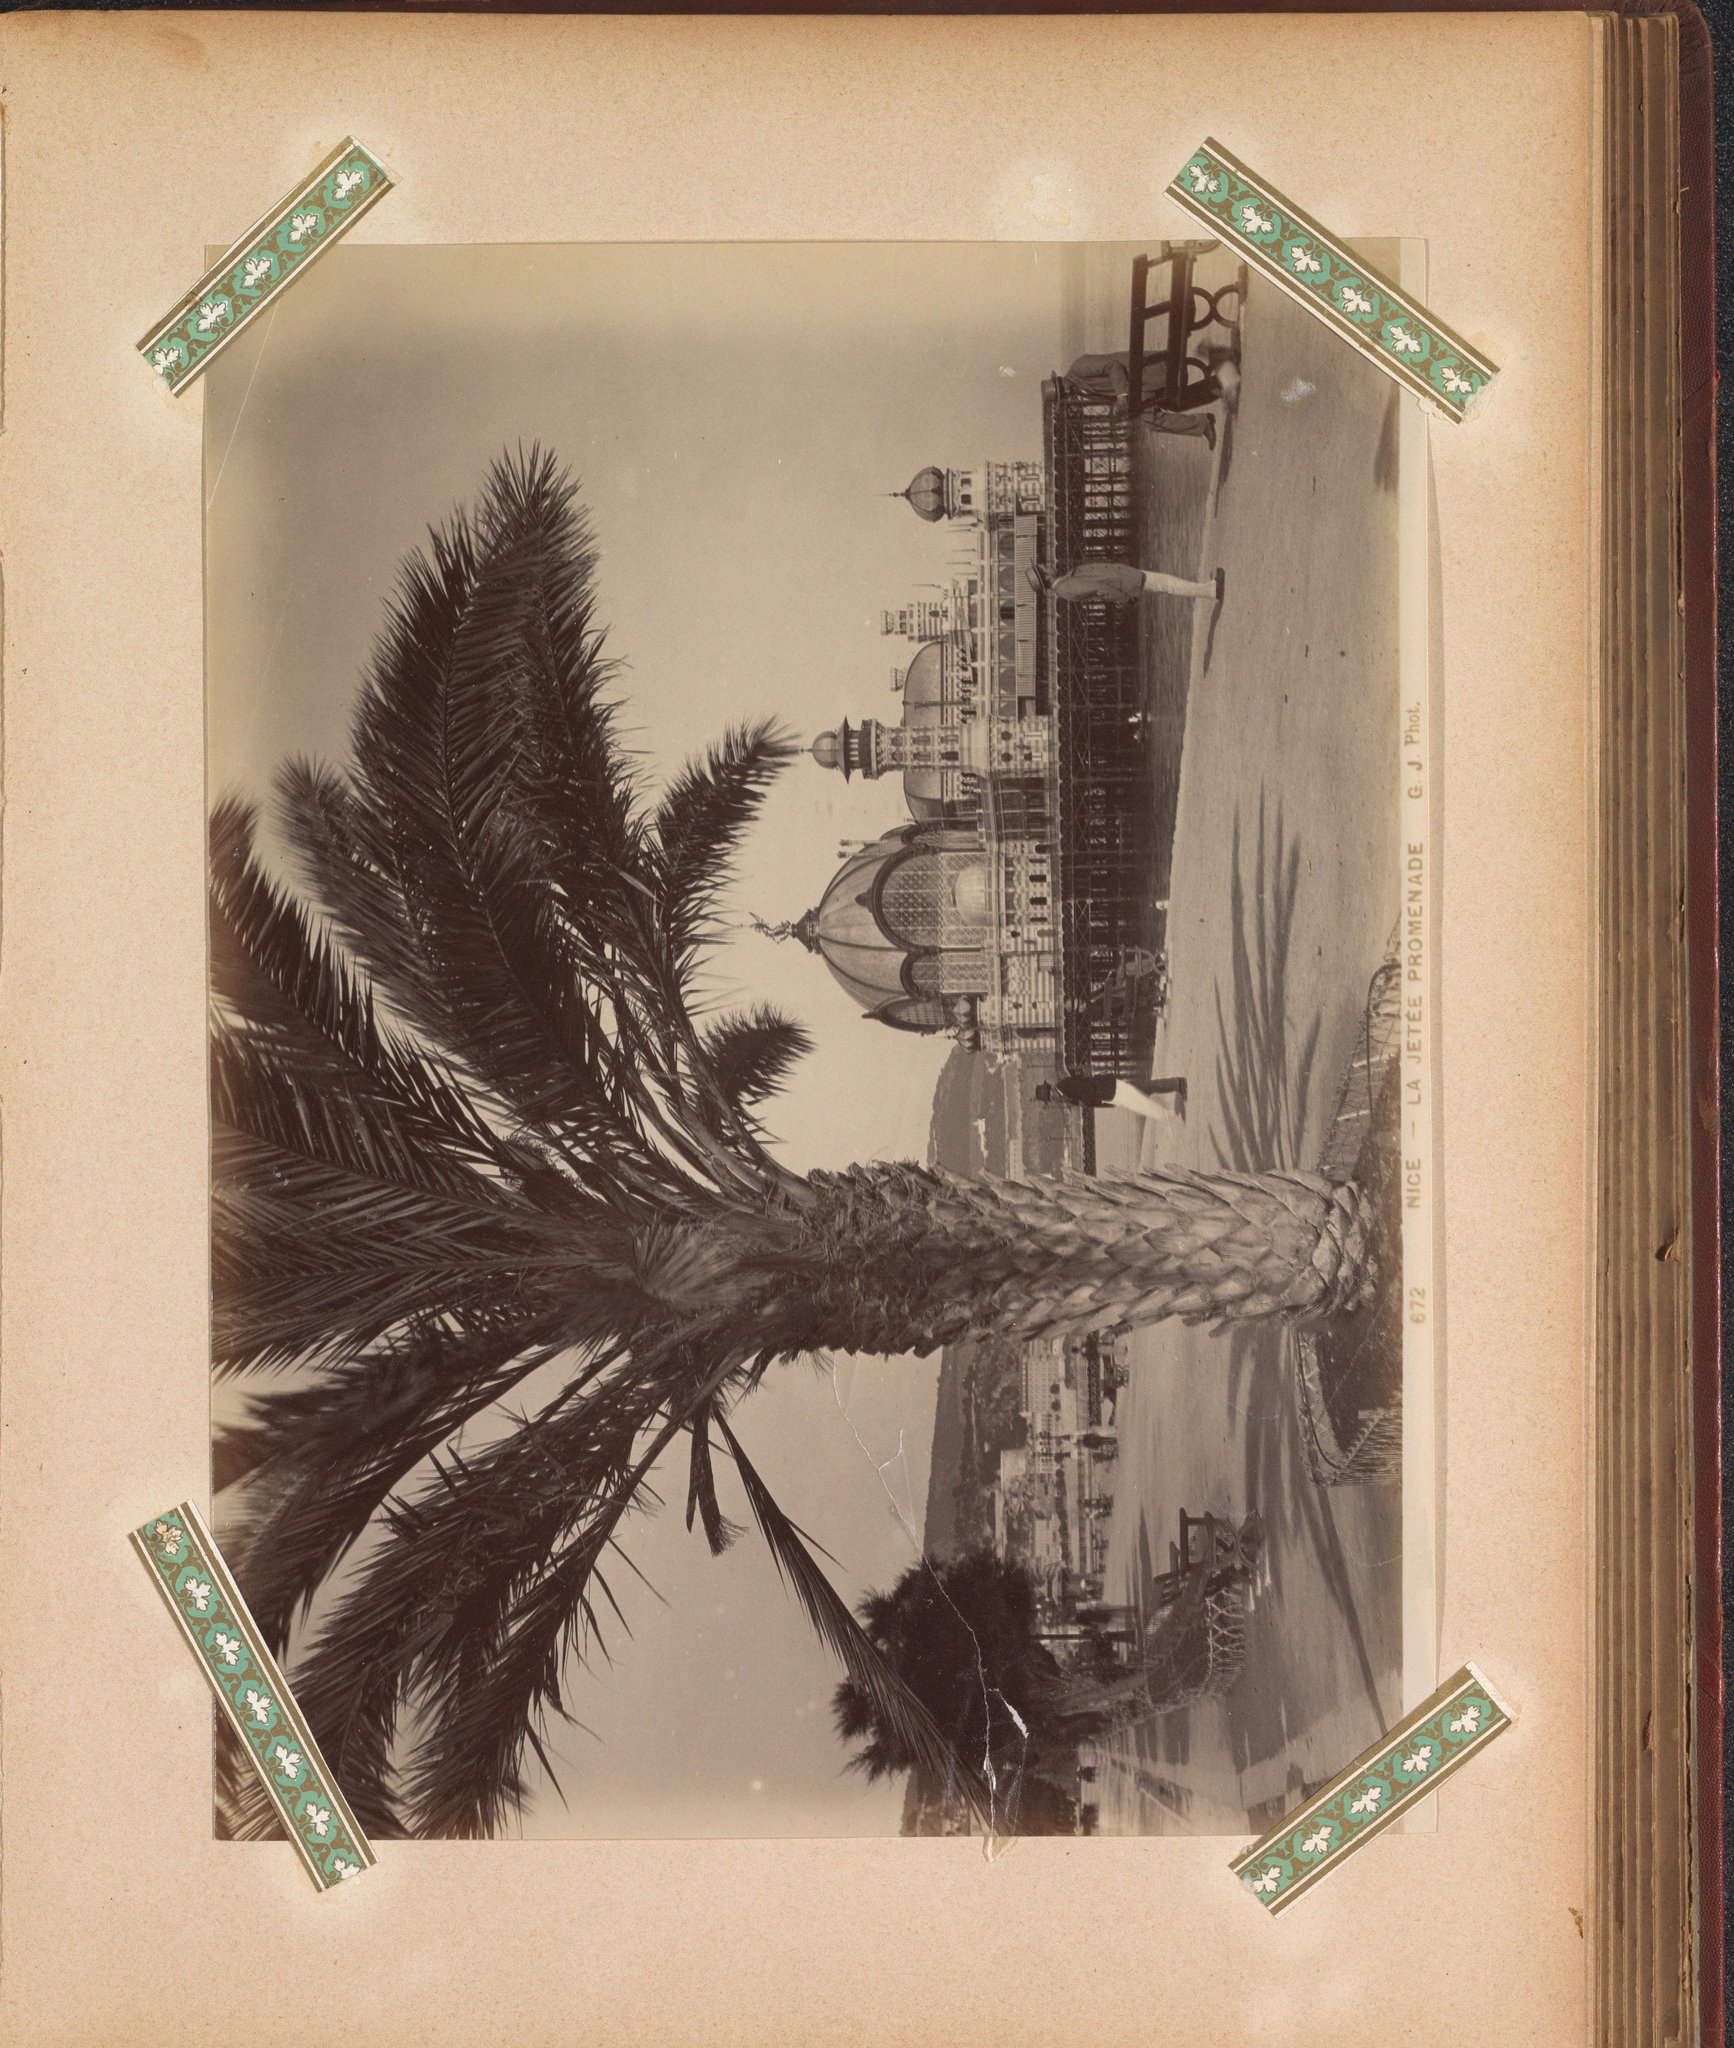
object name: photograph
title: Nice - La Jetée promenade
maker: jean gilletta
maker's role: fotograaf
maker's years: 1856-1933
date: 1890-1900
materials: paper, photographic support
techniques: albumen print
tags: avenue, boulevard, promenade, esplanade (+ city(-scape) with figures, staffage), pier, quay, wharf, trees: palm-tree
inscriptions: negative number: ‘672’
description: Onderdeel van Reisalbum met foto's van bezienswaardigheden in Italië en Zuid-Frankrijk.